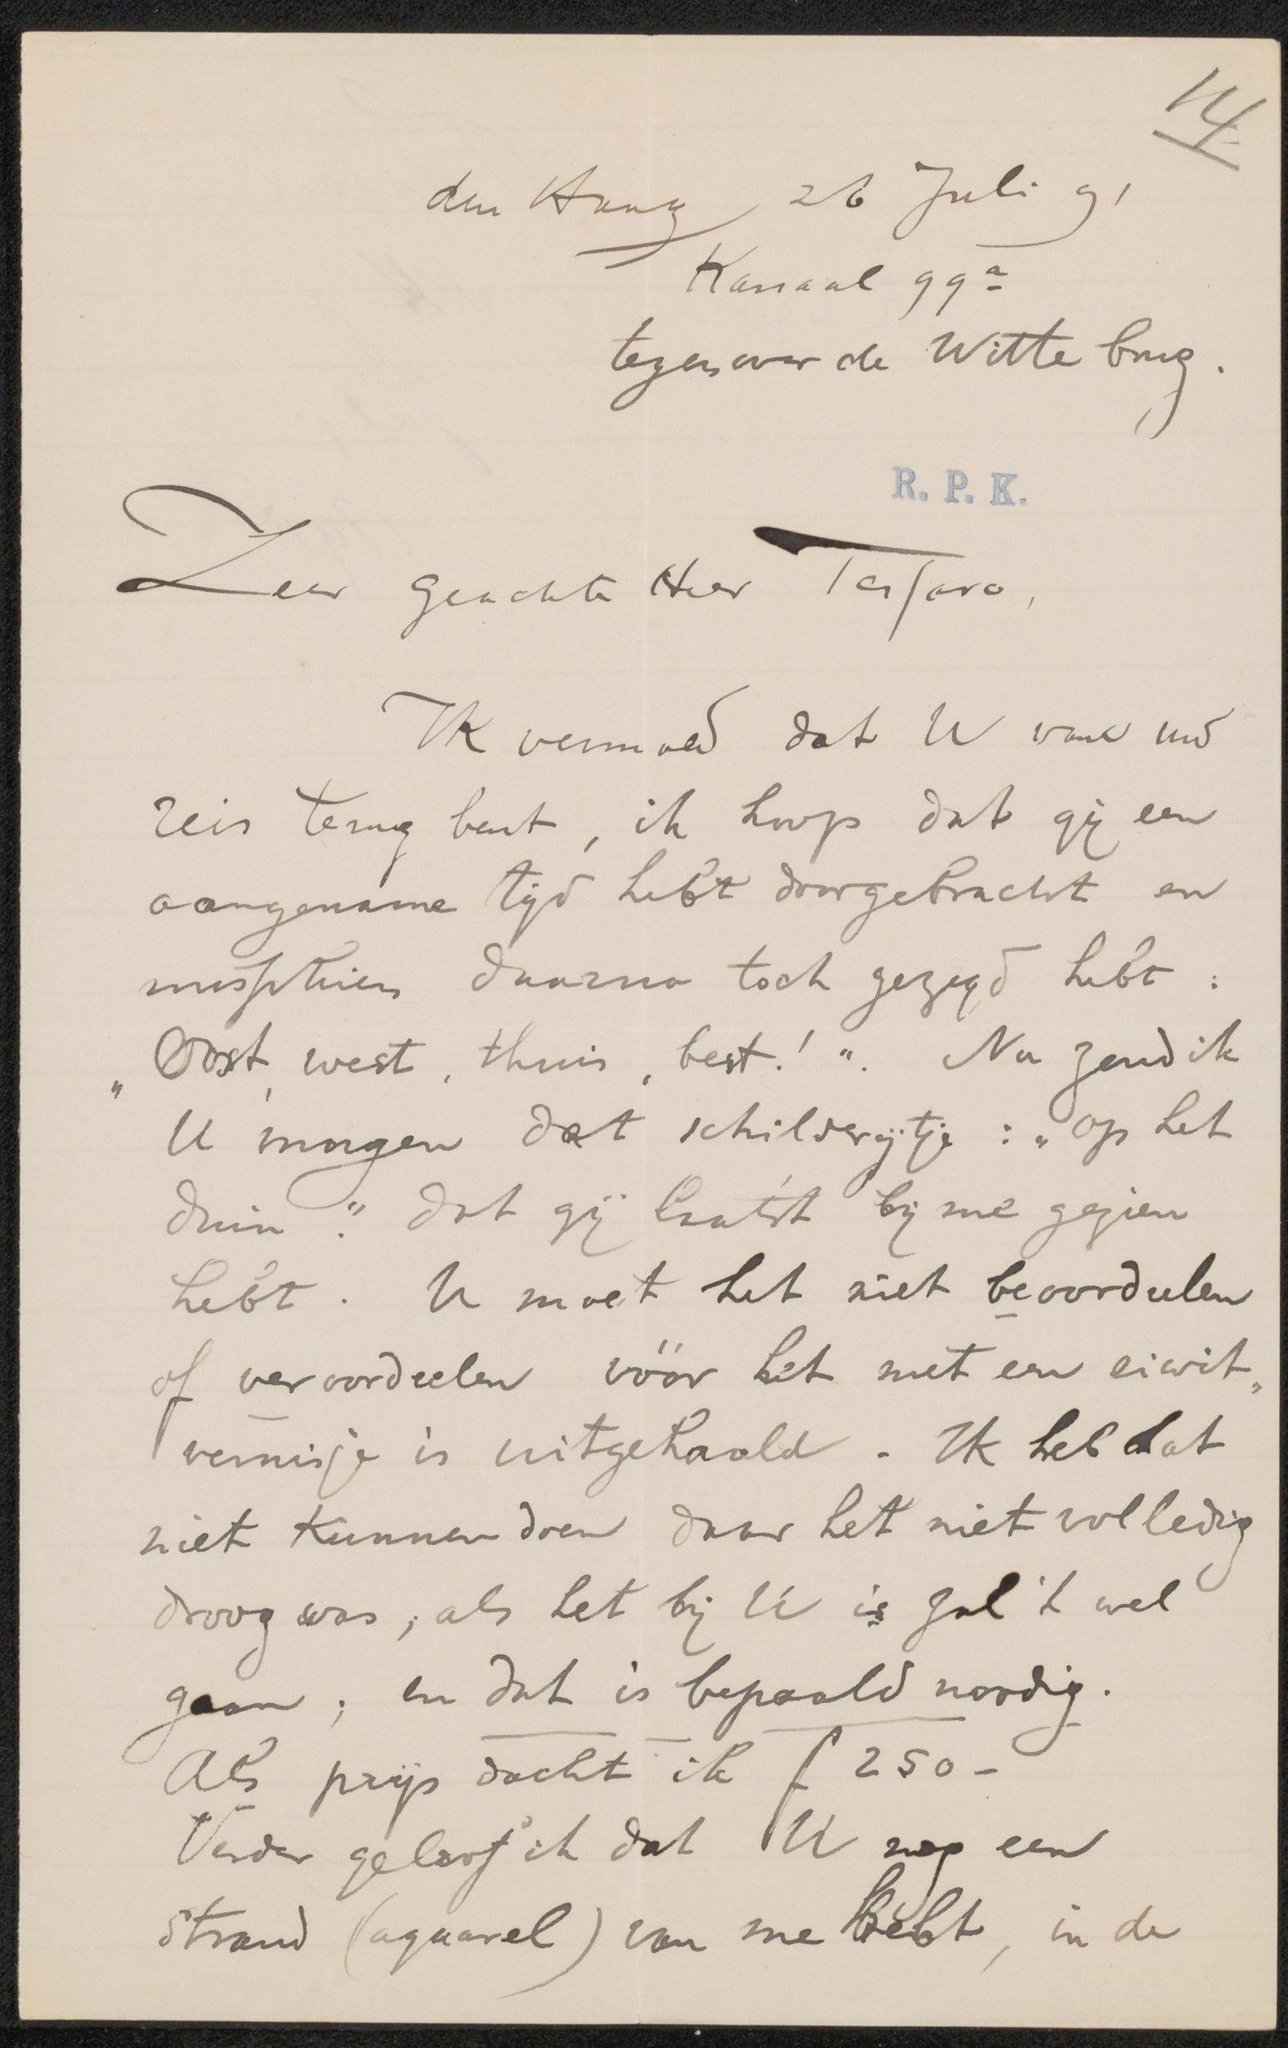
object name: letter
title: Brief aan Filippo Tessaro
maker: willem bastiaan tholen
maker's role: draughtsman, painter, print maker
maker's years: 1860-1931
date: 1891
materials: ink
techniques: pen, writing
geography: the hague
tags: amsterdam, art trade, art shop, travelling; tourism, money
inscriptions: collector's mark: Lugt 2233